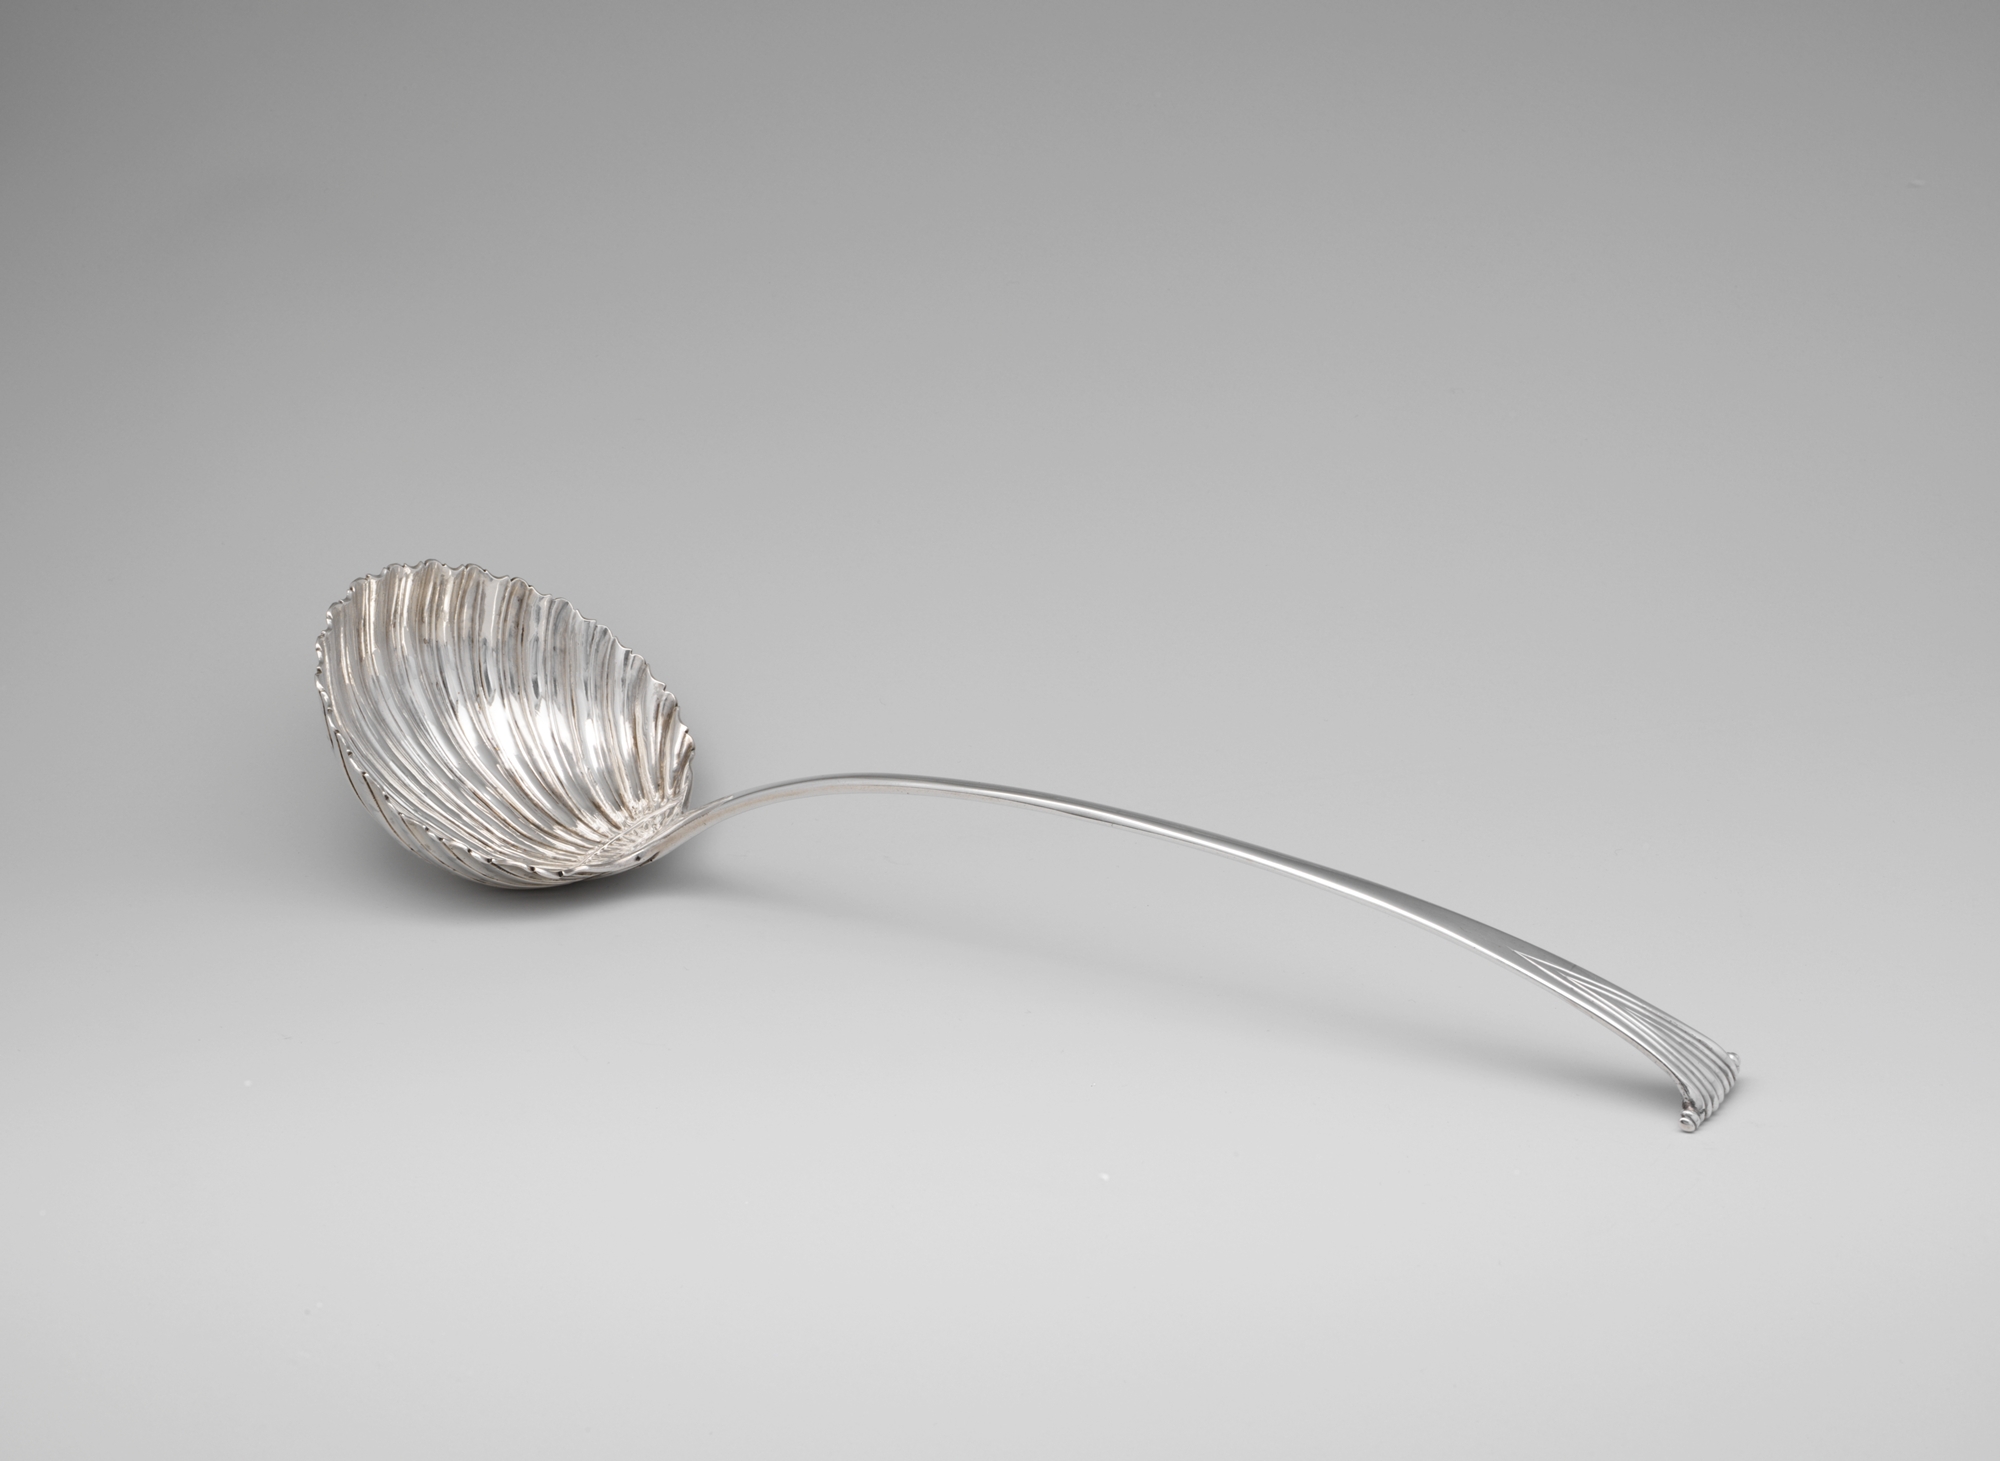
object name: ladle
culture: american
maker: joseph richardson jr.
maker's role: maker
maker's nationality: american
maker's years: 1752-1831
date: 1777-1790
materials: silver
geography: united states